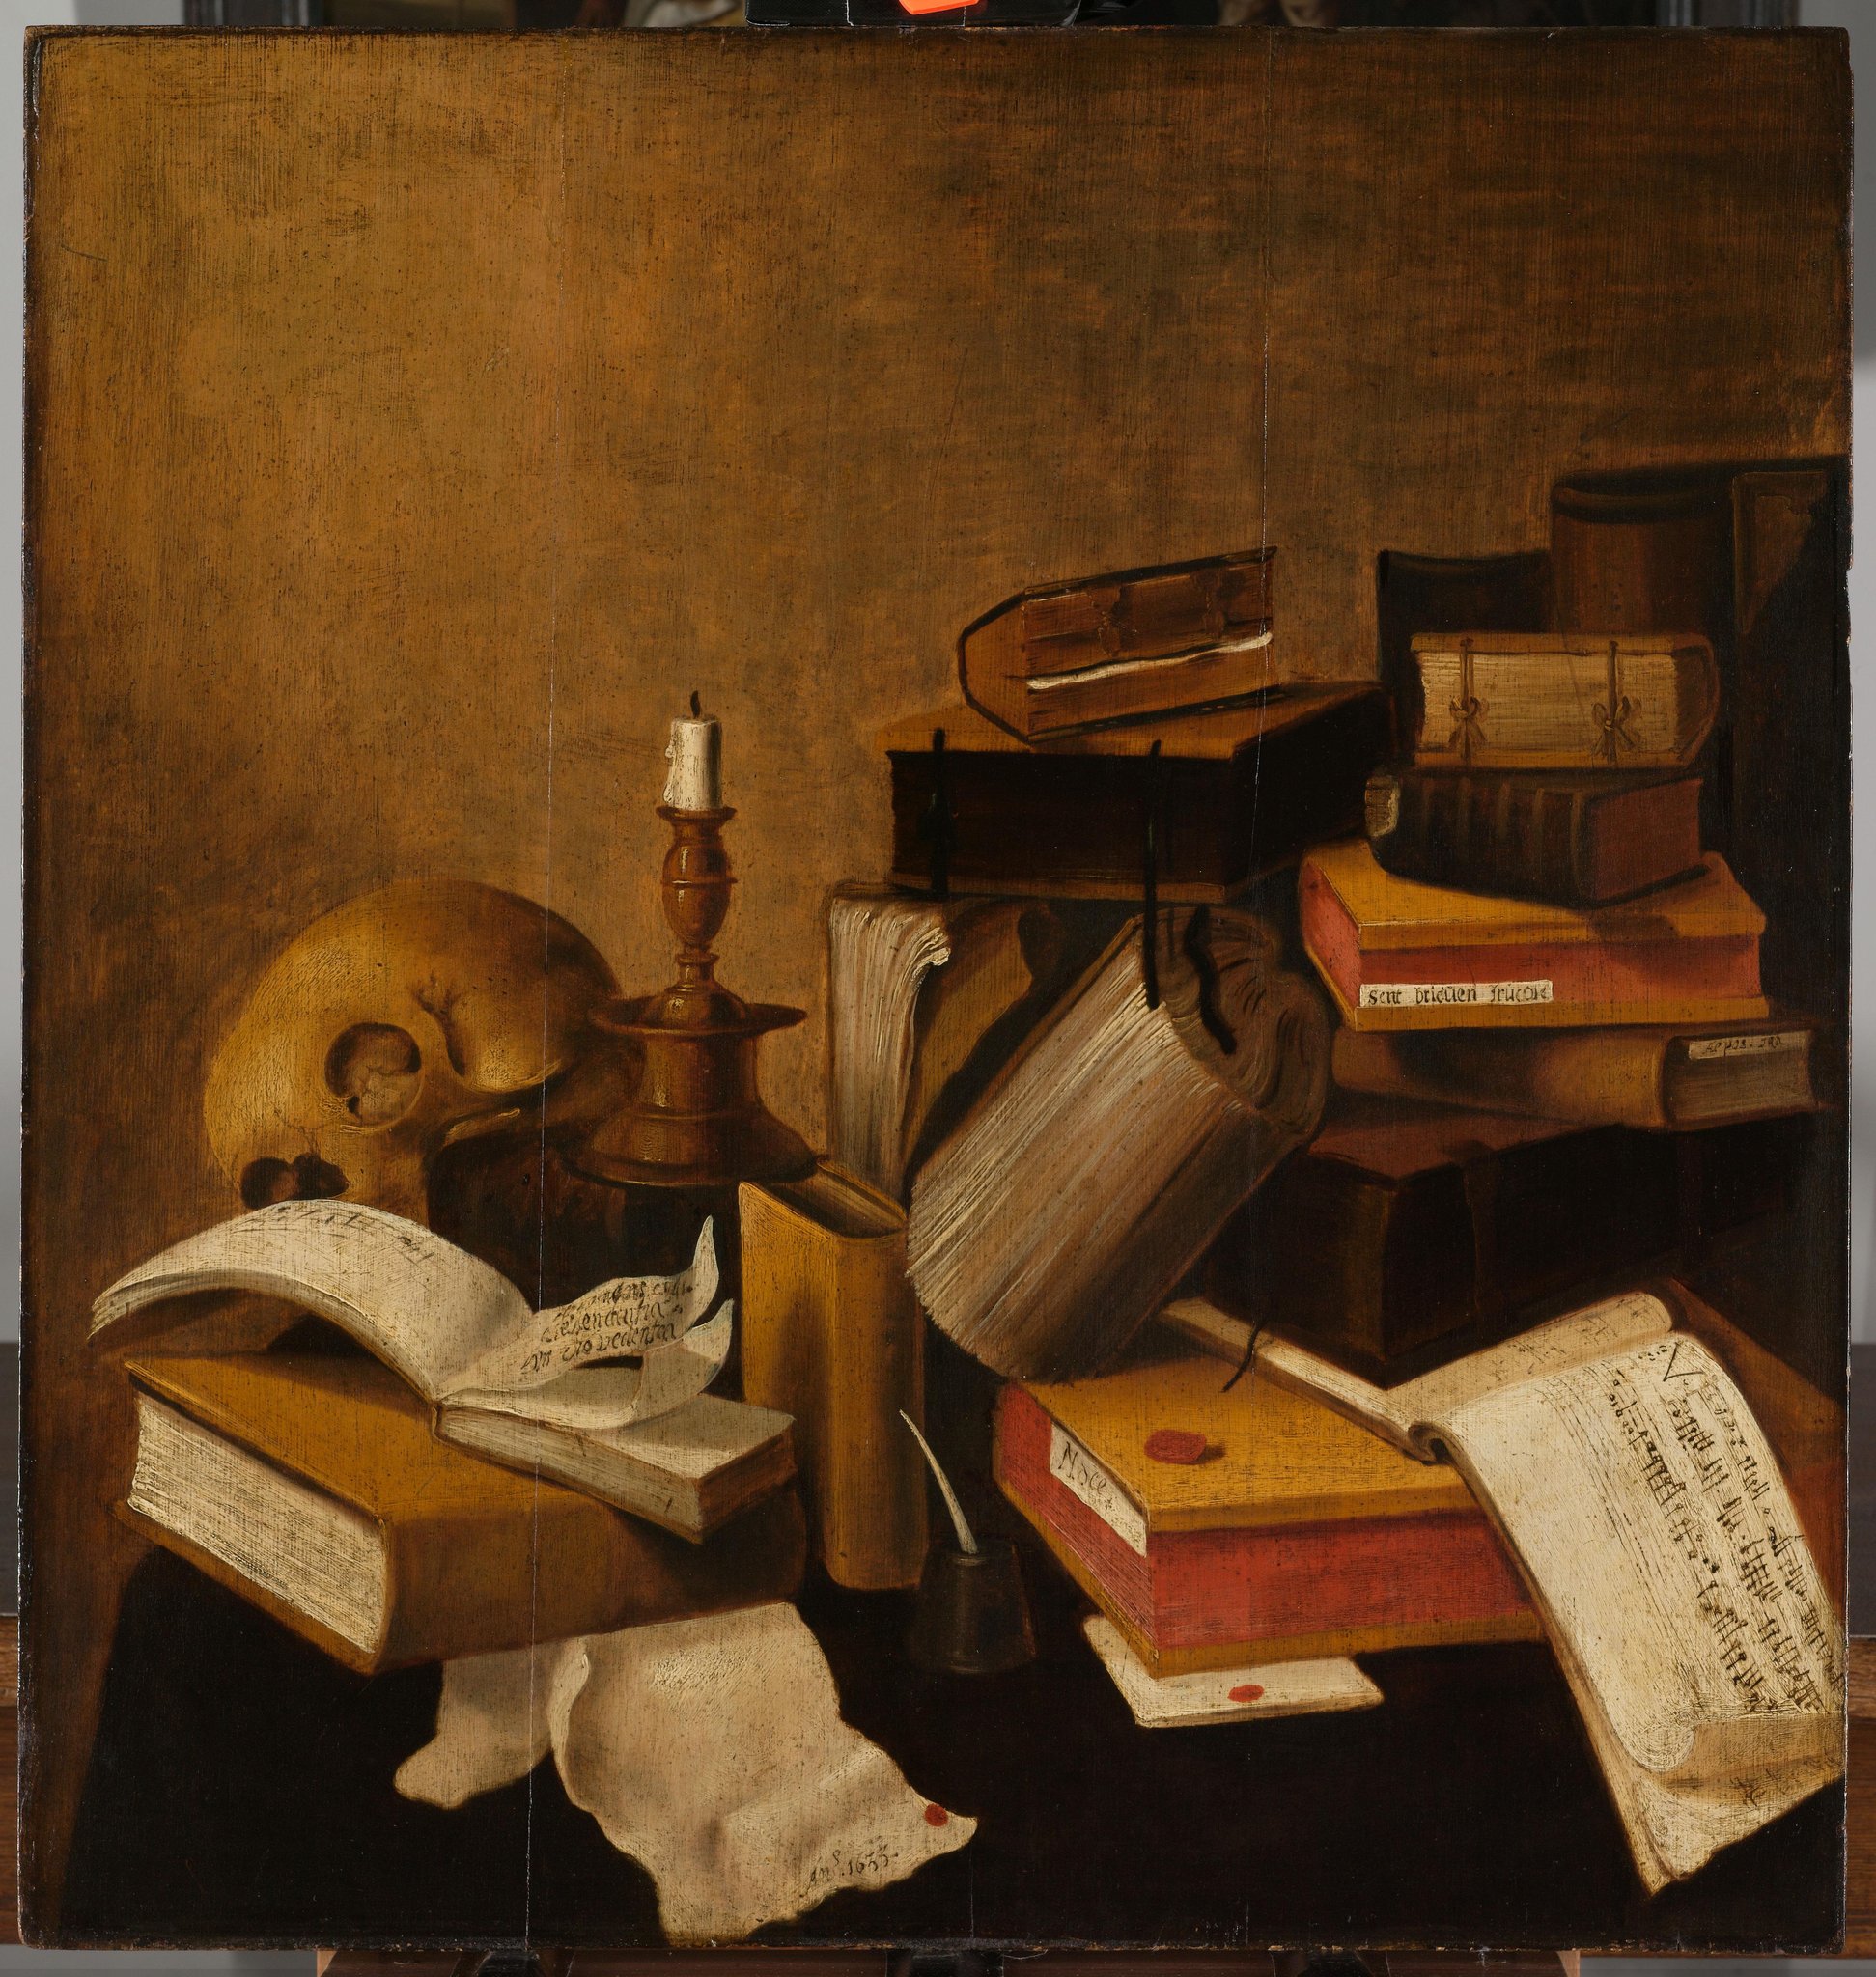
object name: painting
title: Vanitas Still Life with Books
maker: Anonymous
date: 1633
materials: panel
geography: netherlands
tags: notation of music, still life of related objects, book, skull as symbol of 'vanitas', candle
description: Vanitas stilleven met boeken. Stapels van boeken met een schedel, een kaars, enkele documenten met zegels, een inktpot met pen en een liedboek op een tafel.